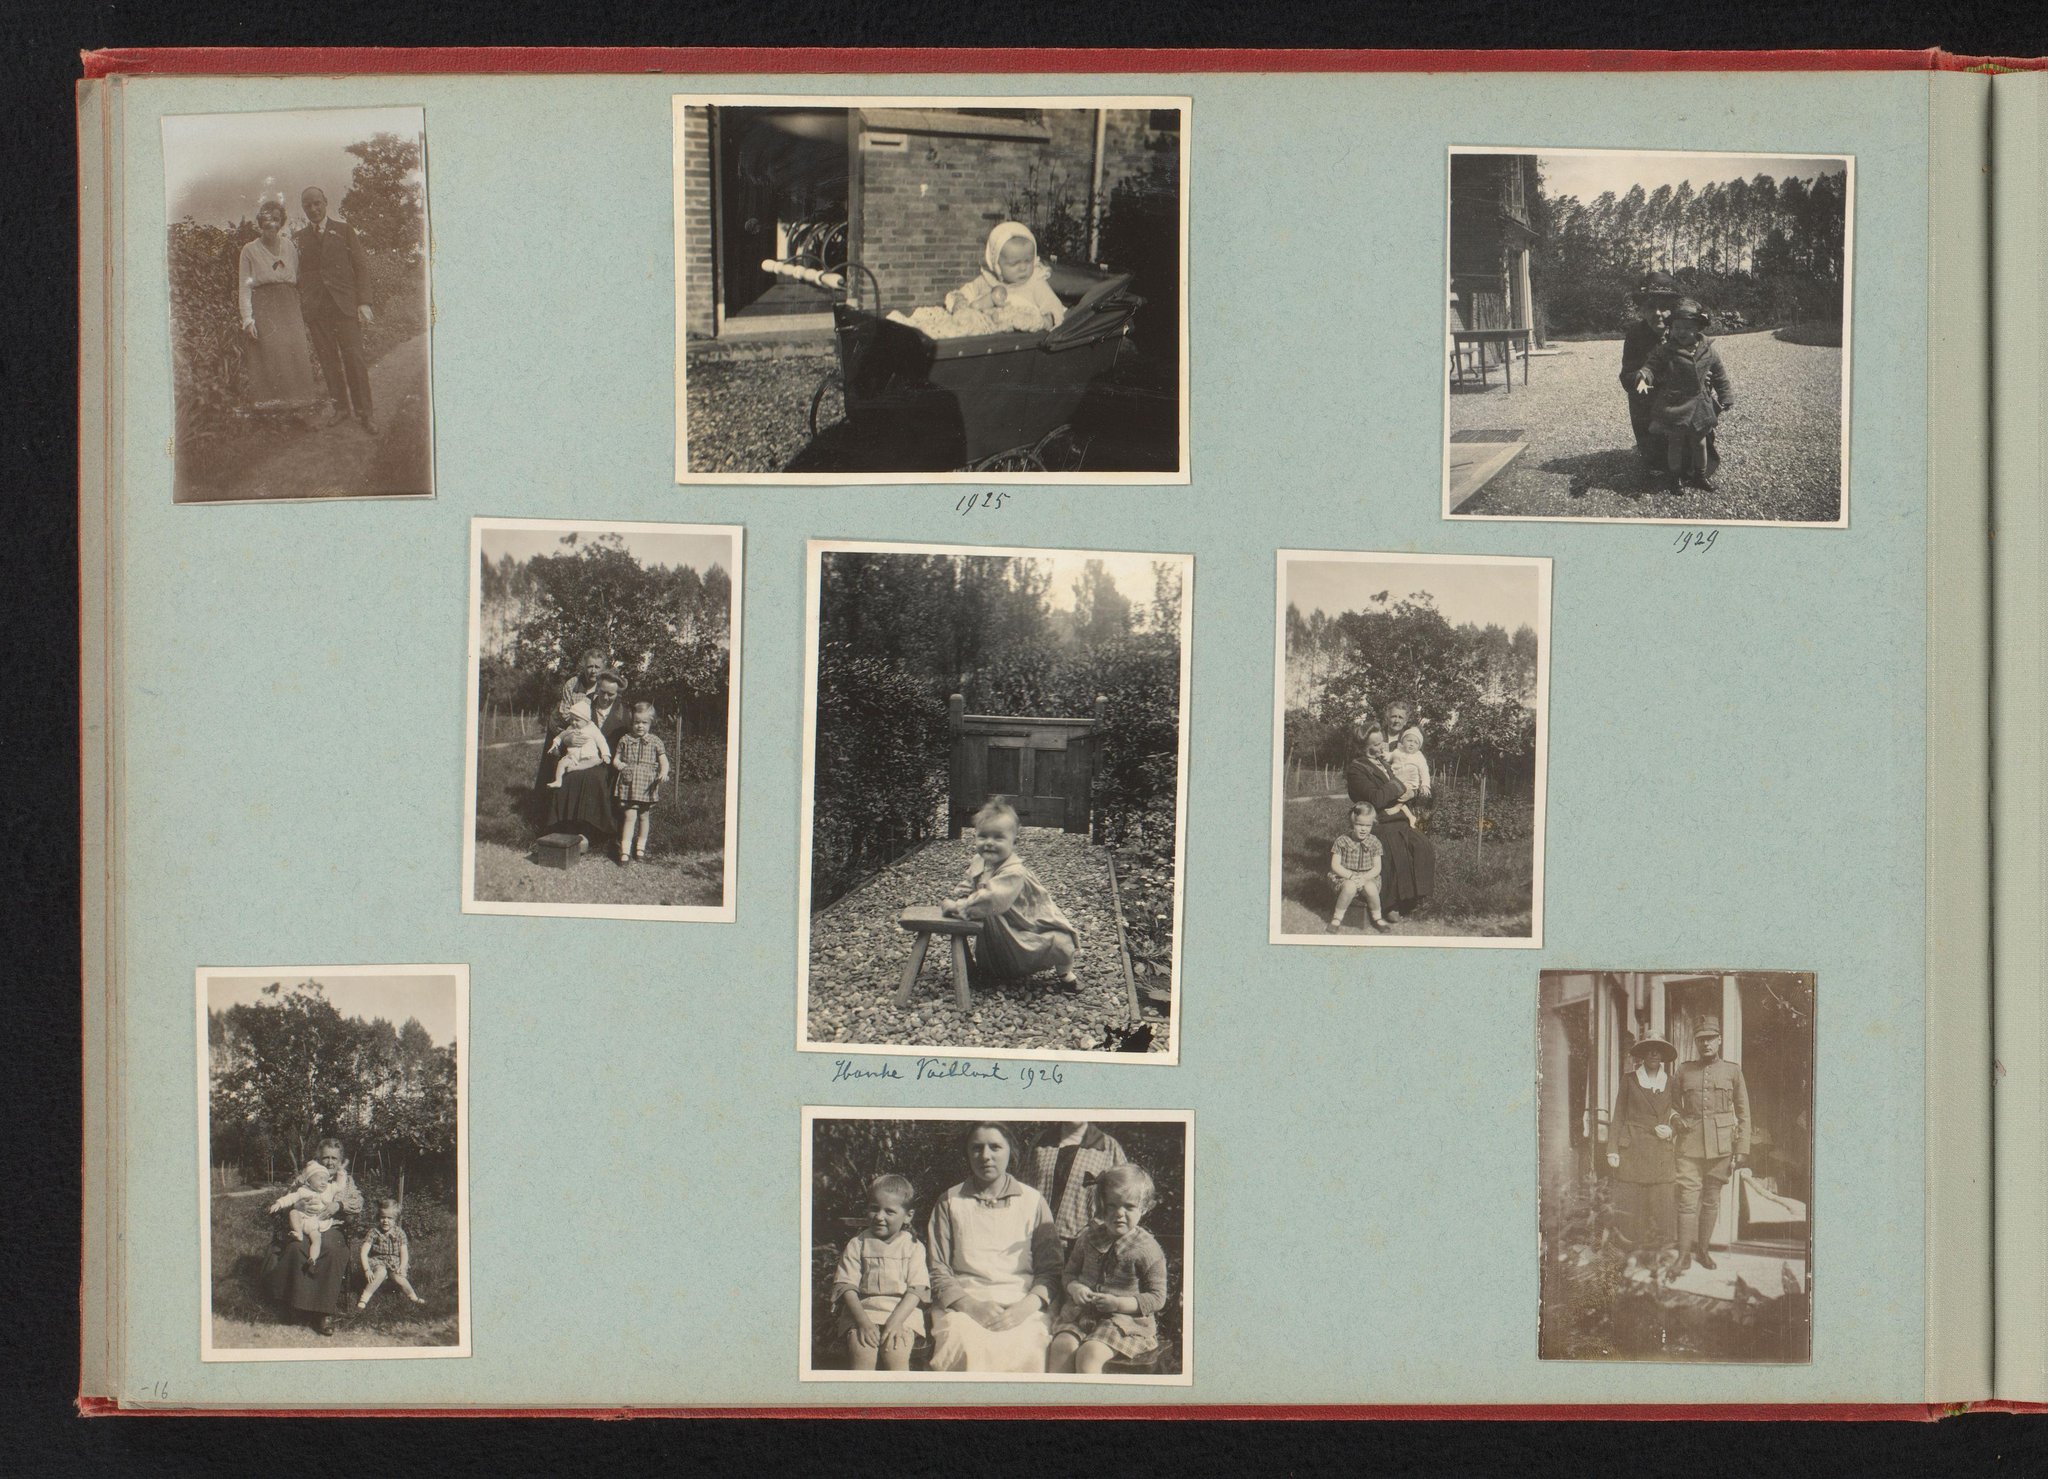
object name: album leaf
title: Verschillende portretten van leden van de familie Graswinckel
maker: Anonymous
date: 1925-1929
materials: paper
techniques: gelatin silver print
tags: anonymous historical person portrayed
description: Deze foto's zijn onderdeel van een album.